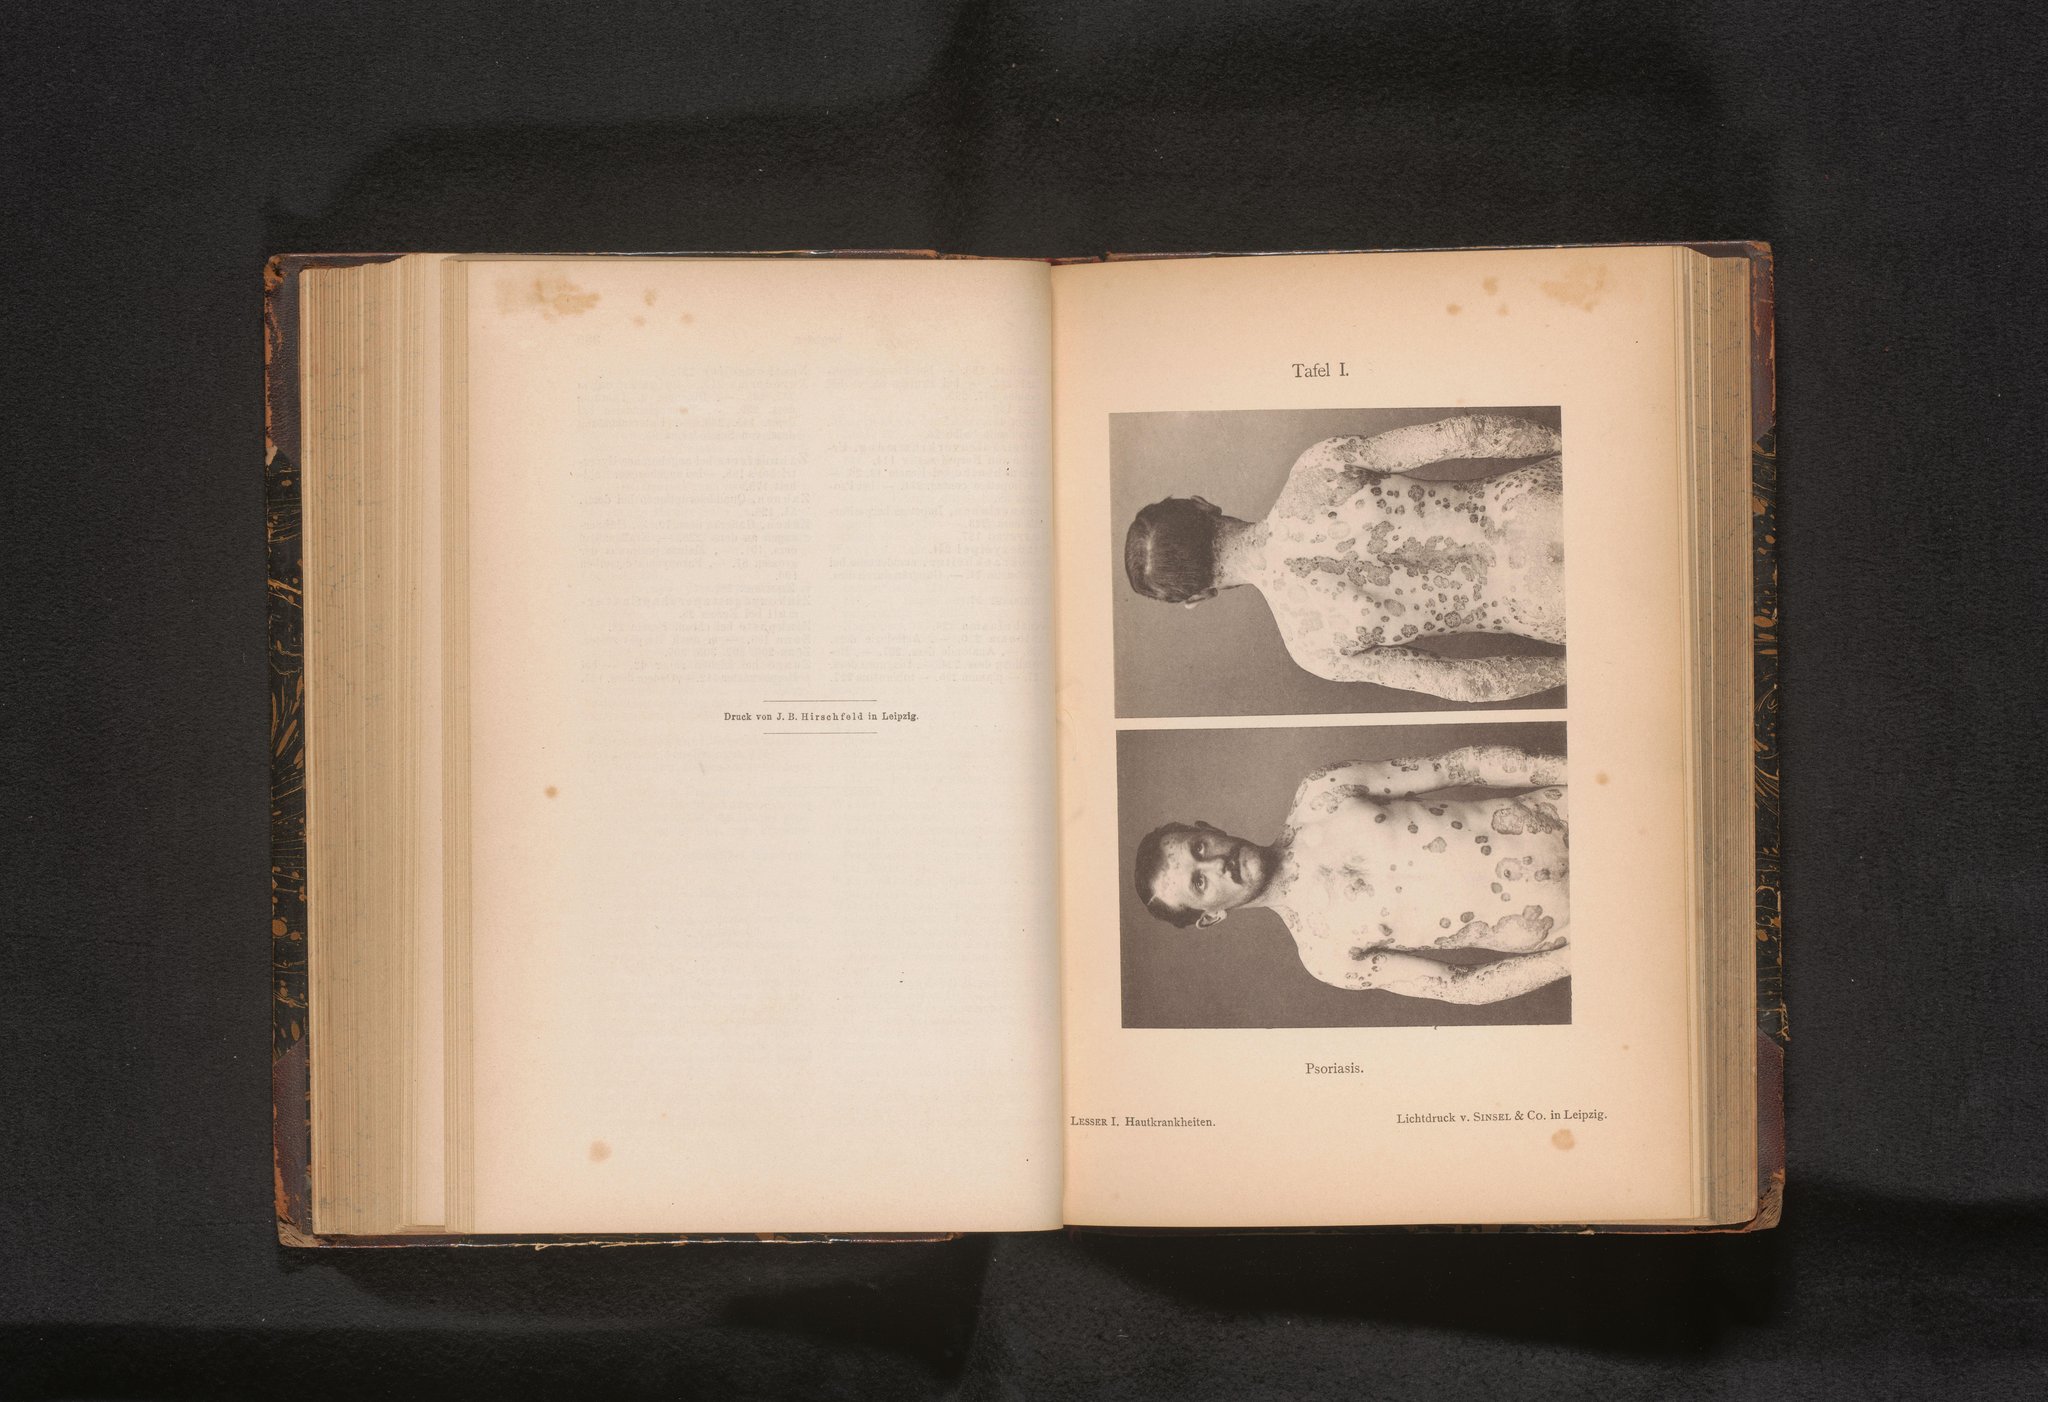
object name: page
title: Tweemaal een onbekende man met psoriasis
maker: Anonymous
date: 1879-1889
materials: paper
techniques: photograph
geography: leipzig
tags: skin and venereal diseases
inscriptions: number: ‘Tafel I.’